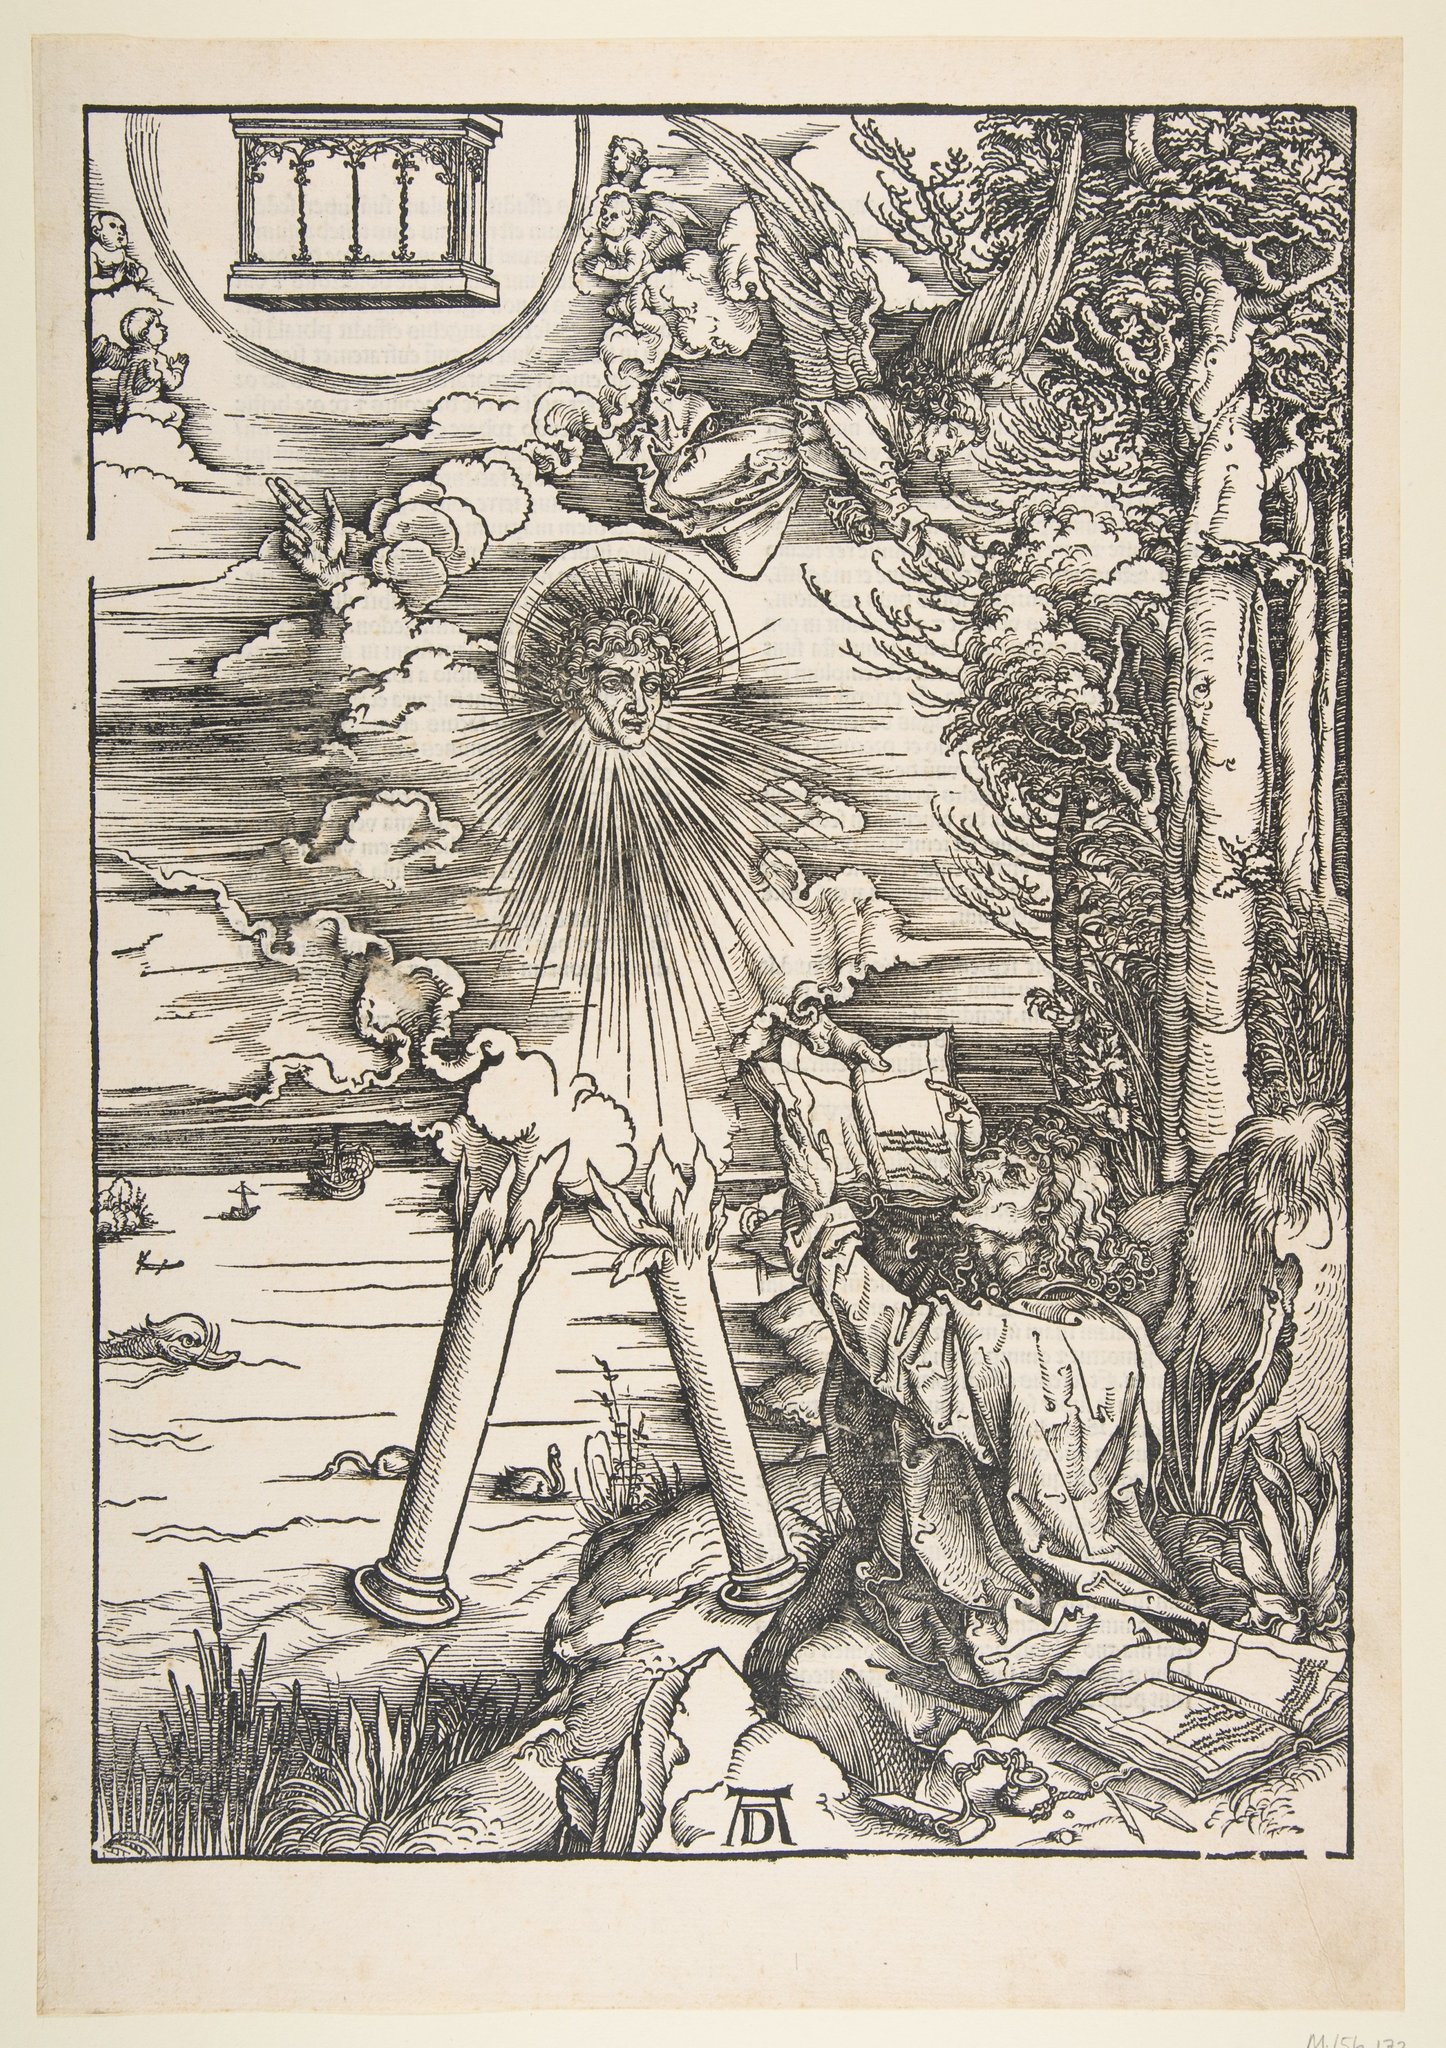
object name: print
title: Saint John Devouring the Book, from "The Apocalypse"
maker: albrecht dürer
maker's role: artist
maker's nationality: german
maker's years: 1471-1528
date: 1498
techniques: woodcut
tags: books,angels,saint john the baptist,apocalypse